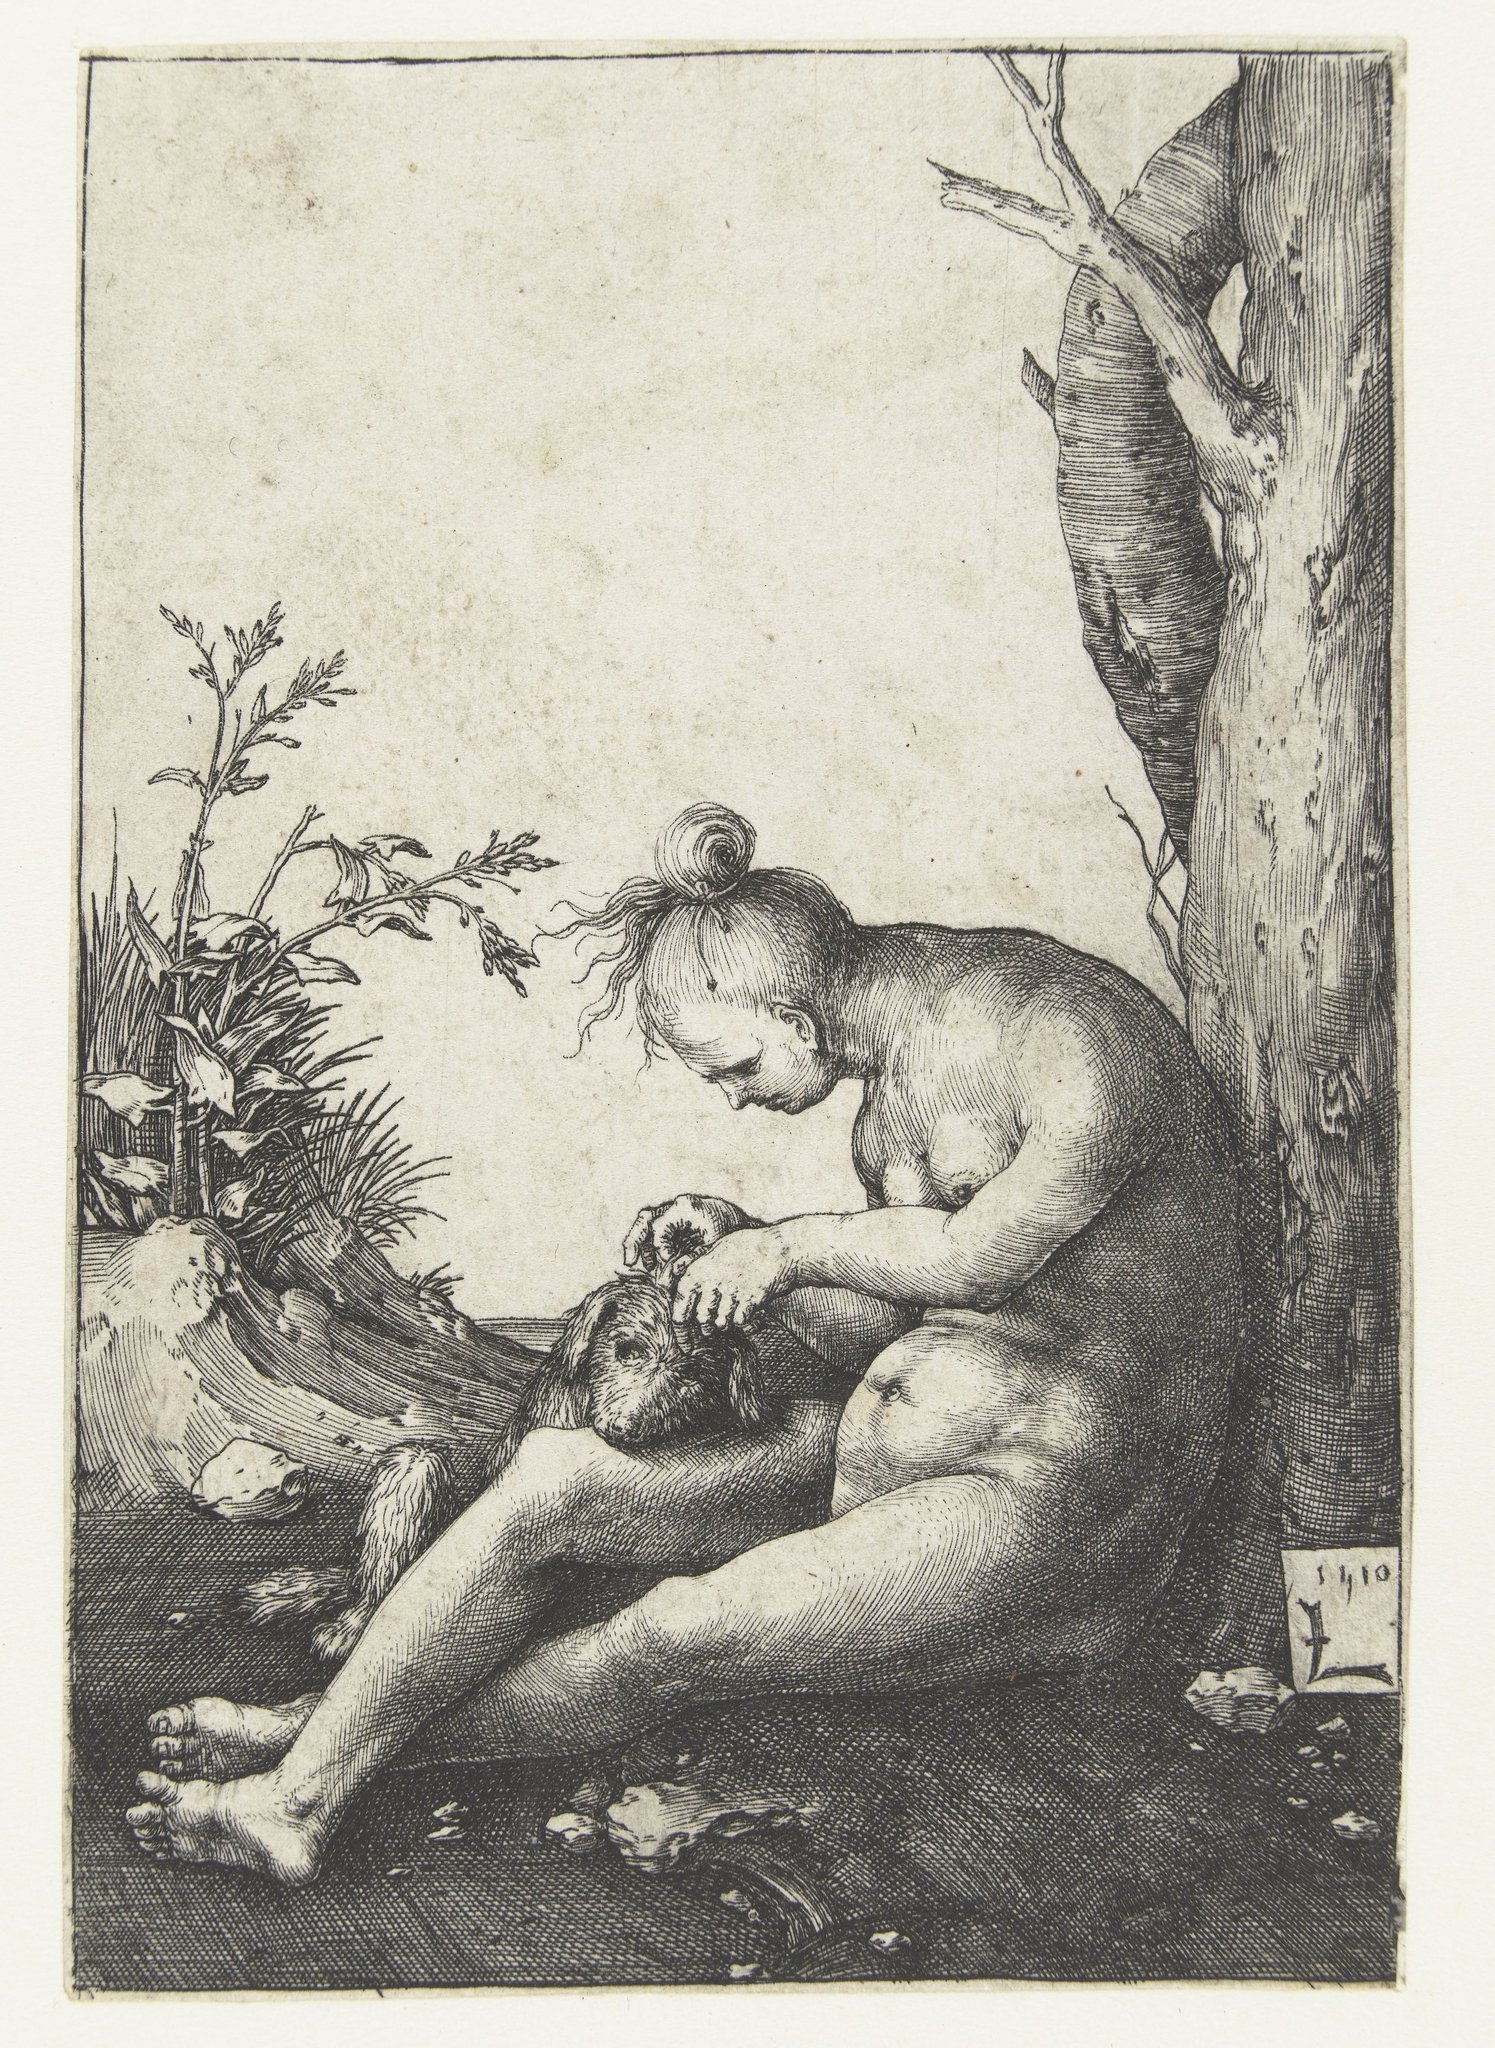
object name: print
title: Naakte vrouw met hond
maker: lucas van leyden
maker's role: draughtsman, painter, print maker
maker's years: 1494-1533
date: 1510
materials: paper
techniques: engraving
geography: low countries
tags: female sex; woman, dog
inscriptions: collector's mark: Lugt 240, signature and date: ‘L 1510’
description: Naakte vrouw zittend tegen een boom, vlooit een hond.